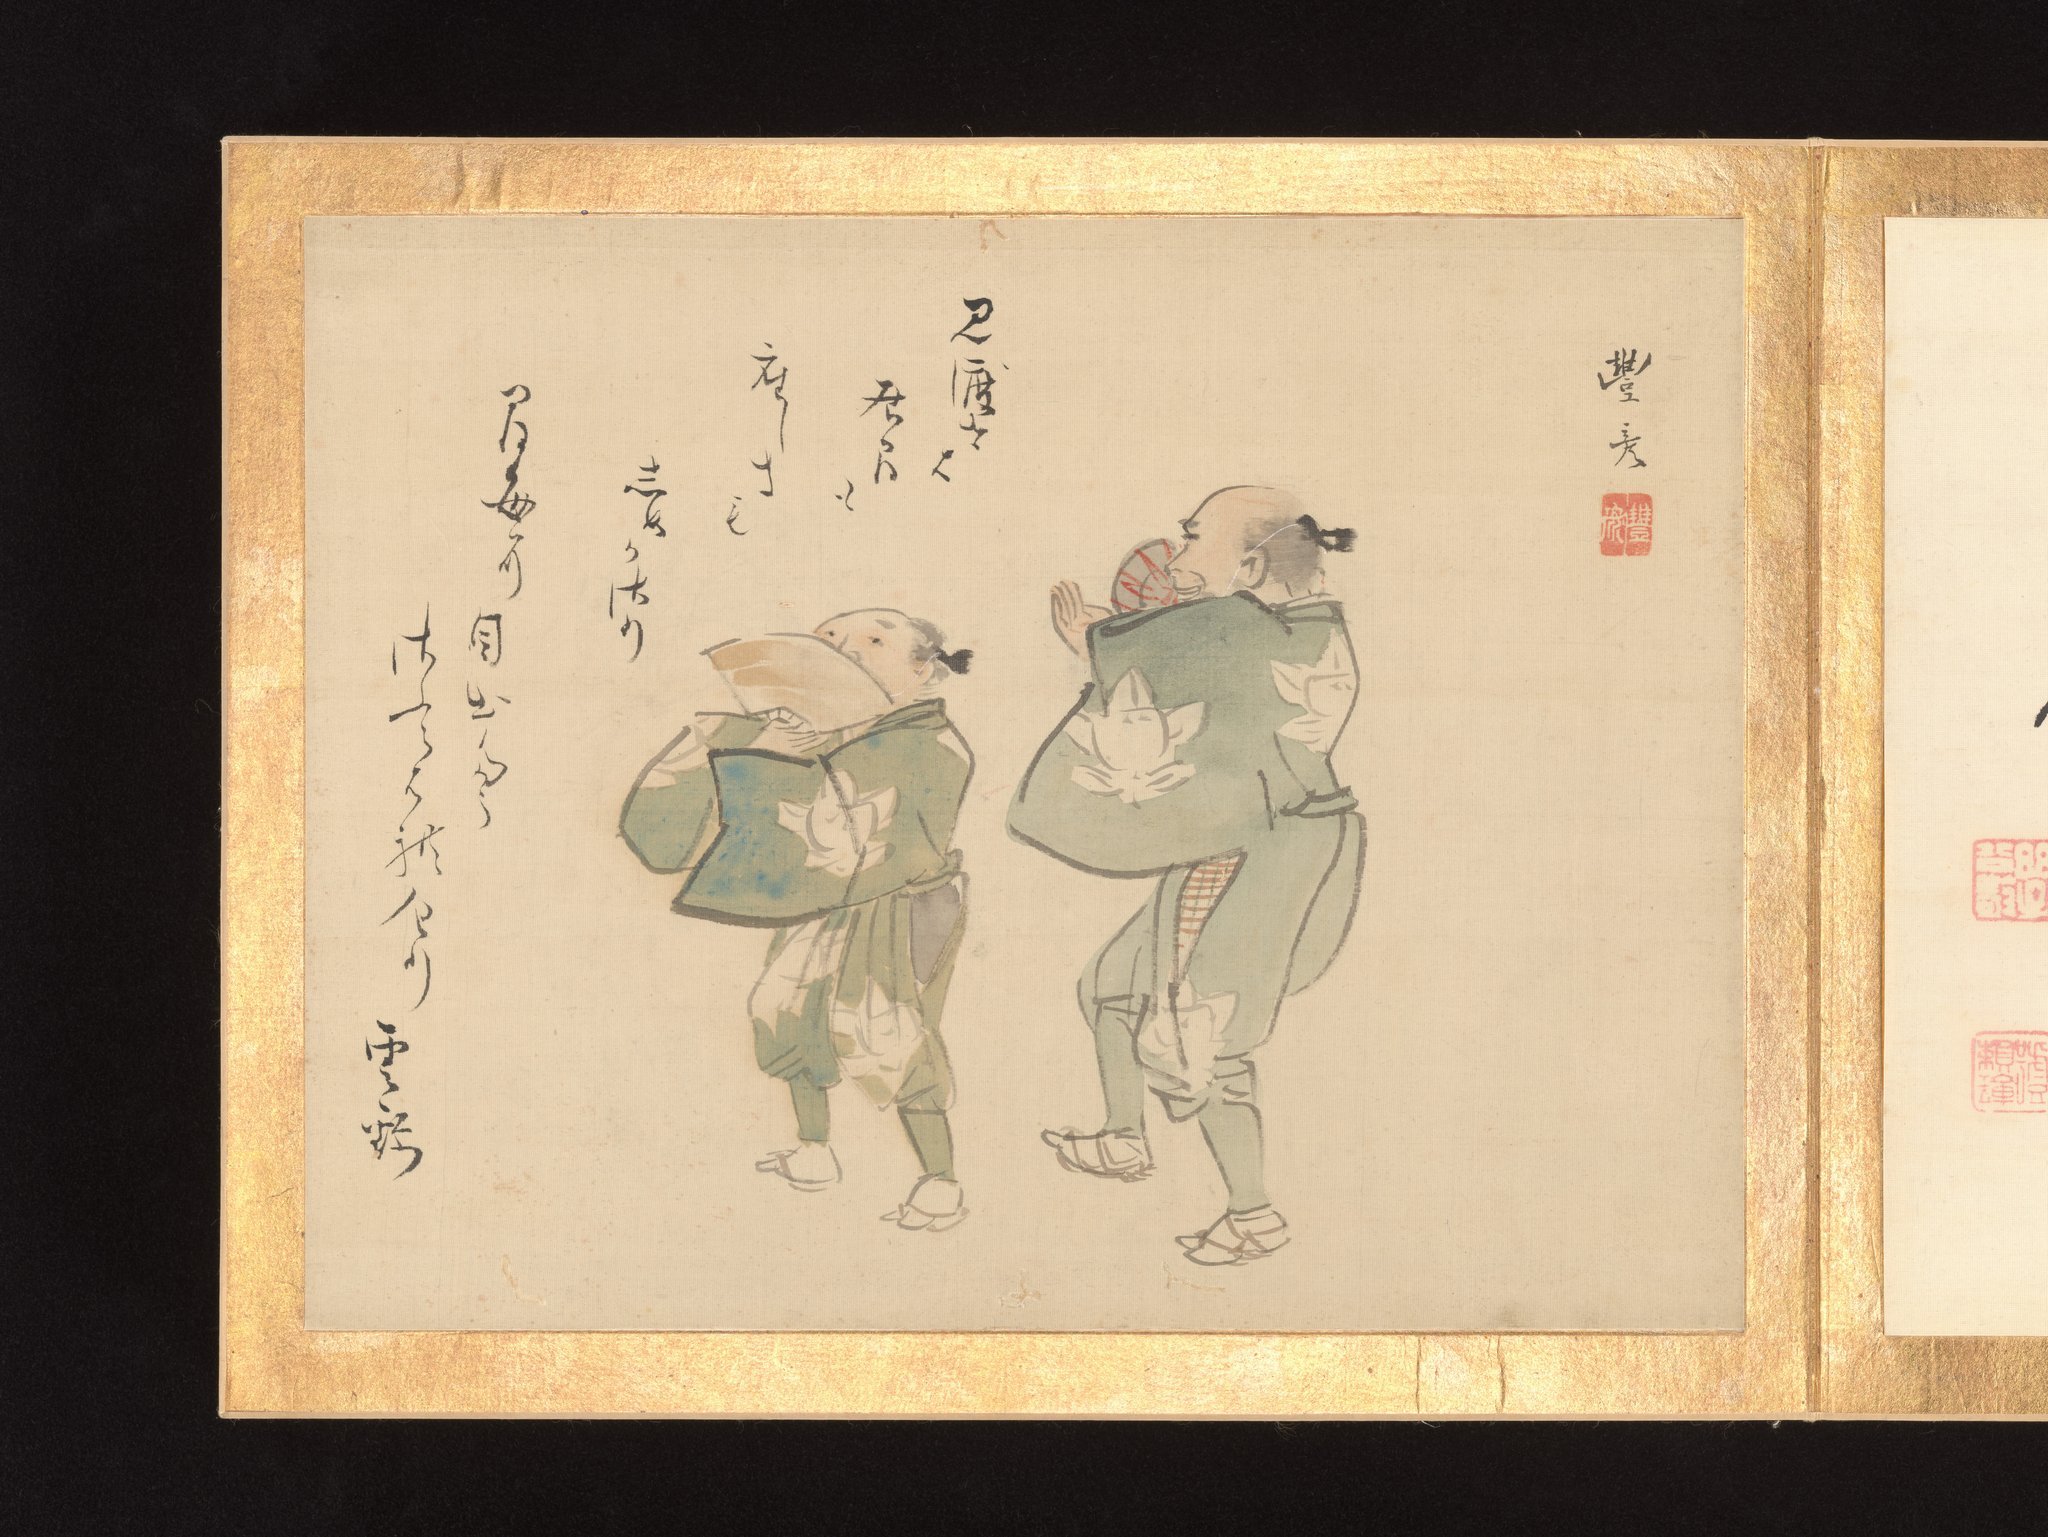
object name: album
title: Painting Album of Sublime Talent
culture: japanese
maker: various artists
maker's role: artist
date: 1815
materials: ink, silk